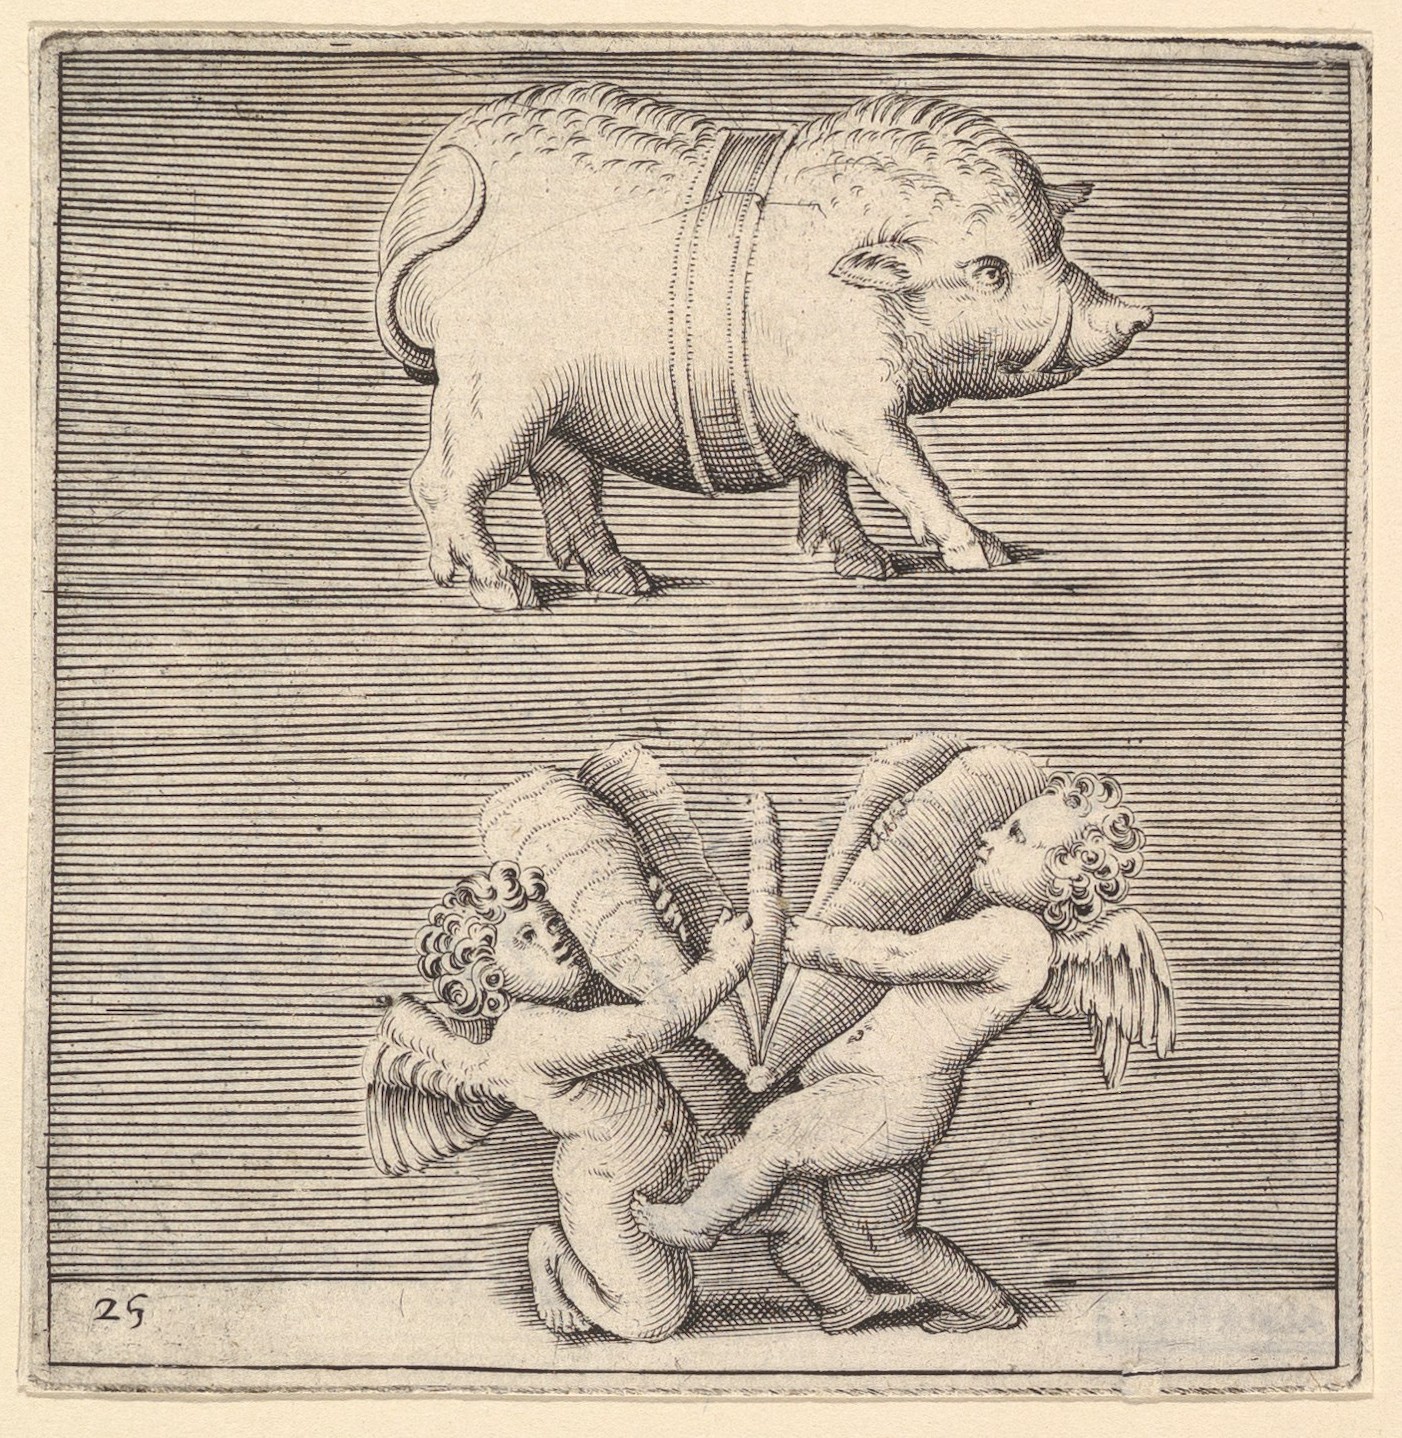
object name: print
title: A Belted Pig and Two Cupids (or Geniuses) with a Butterfly (or Moth), from "Ex Antiquis Cameorum et Gemmae Delineata/ Liber Secundus/et ab Enea Vico Parmen Incis"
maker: anonymous, italian, 16th century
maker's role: artist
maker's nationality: italian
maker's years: 1500-1600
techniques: engraving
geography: rome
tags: cupid,butterflies,pigs